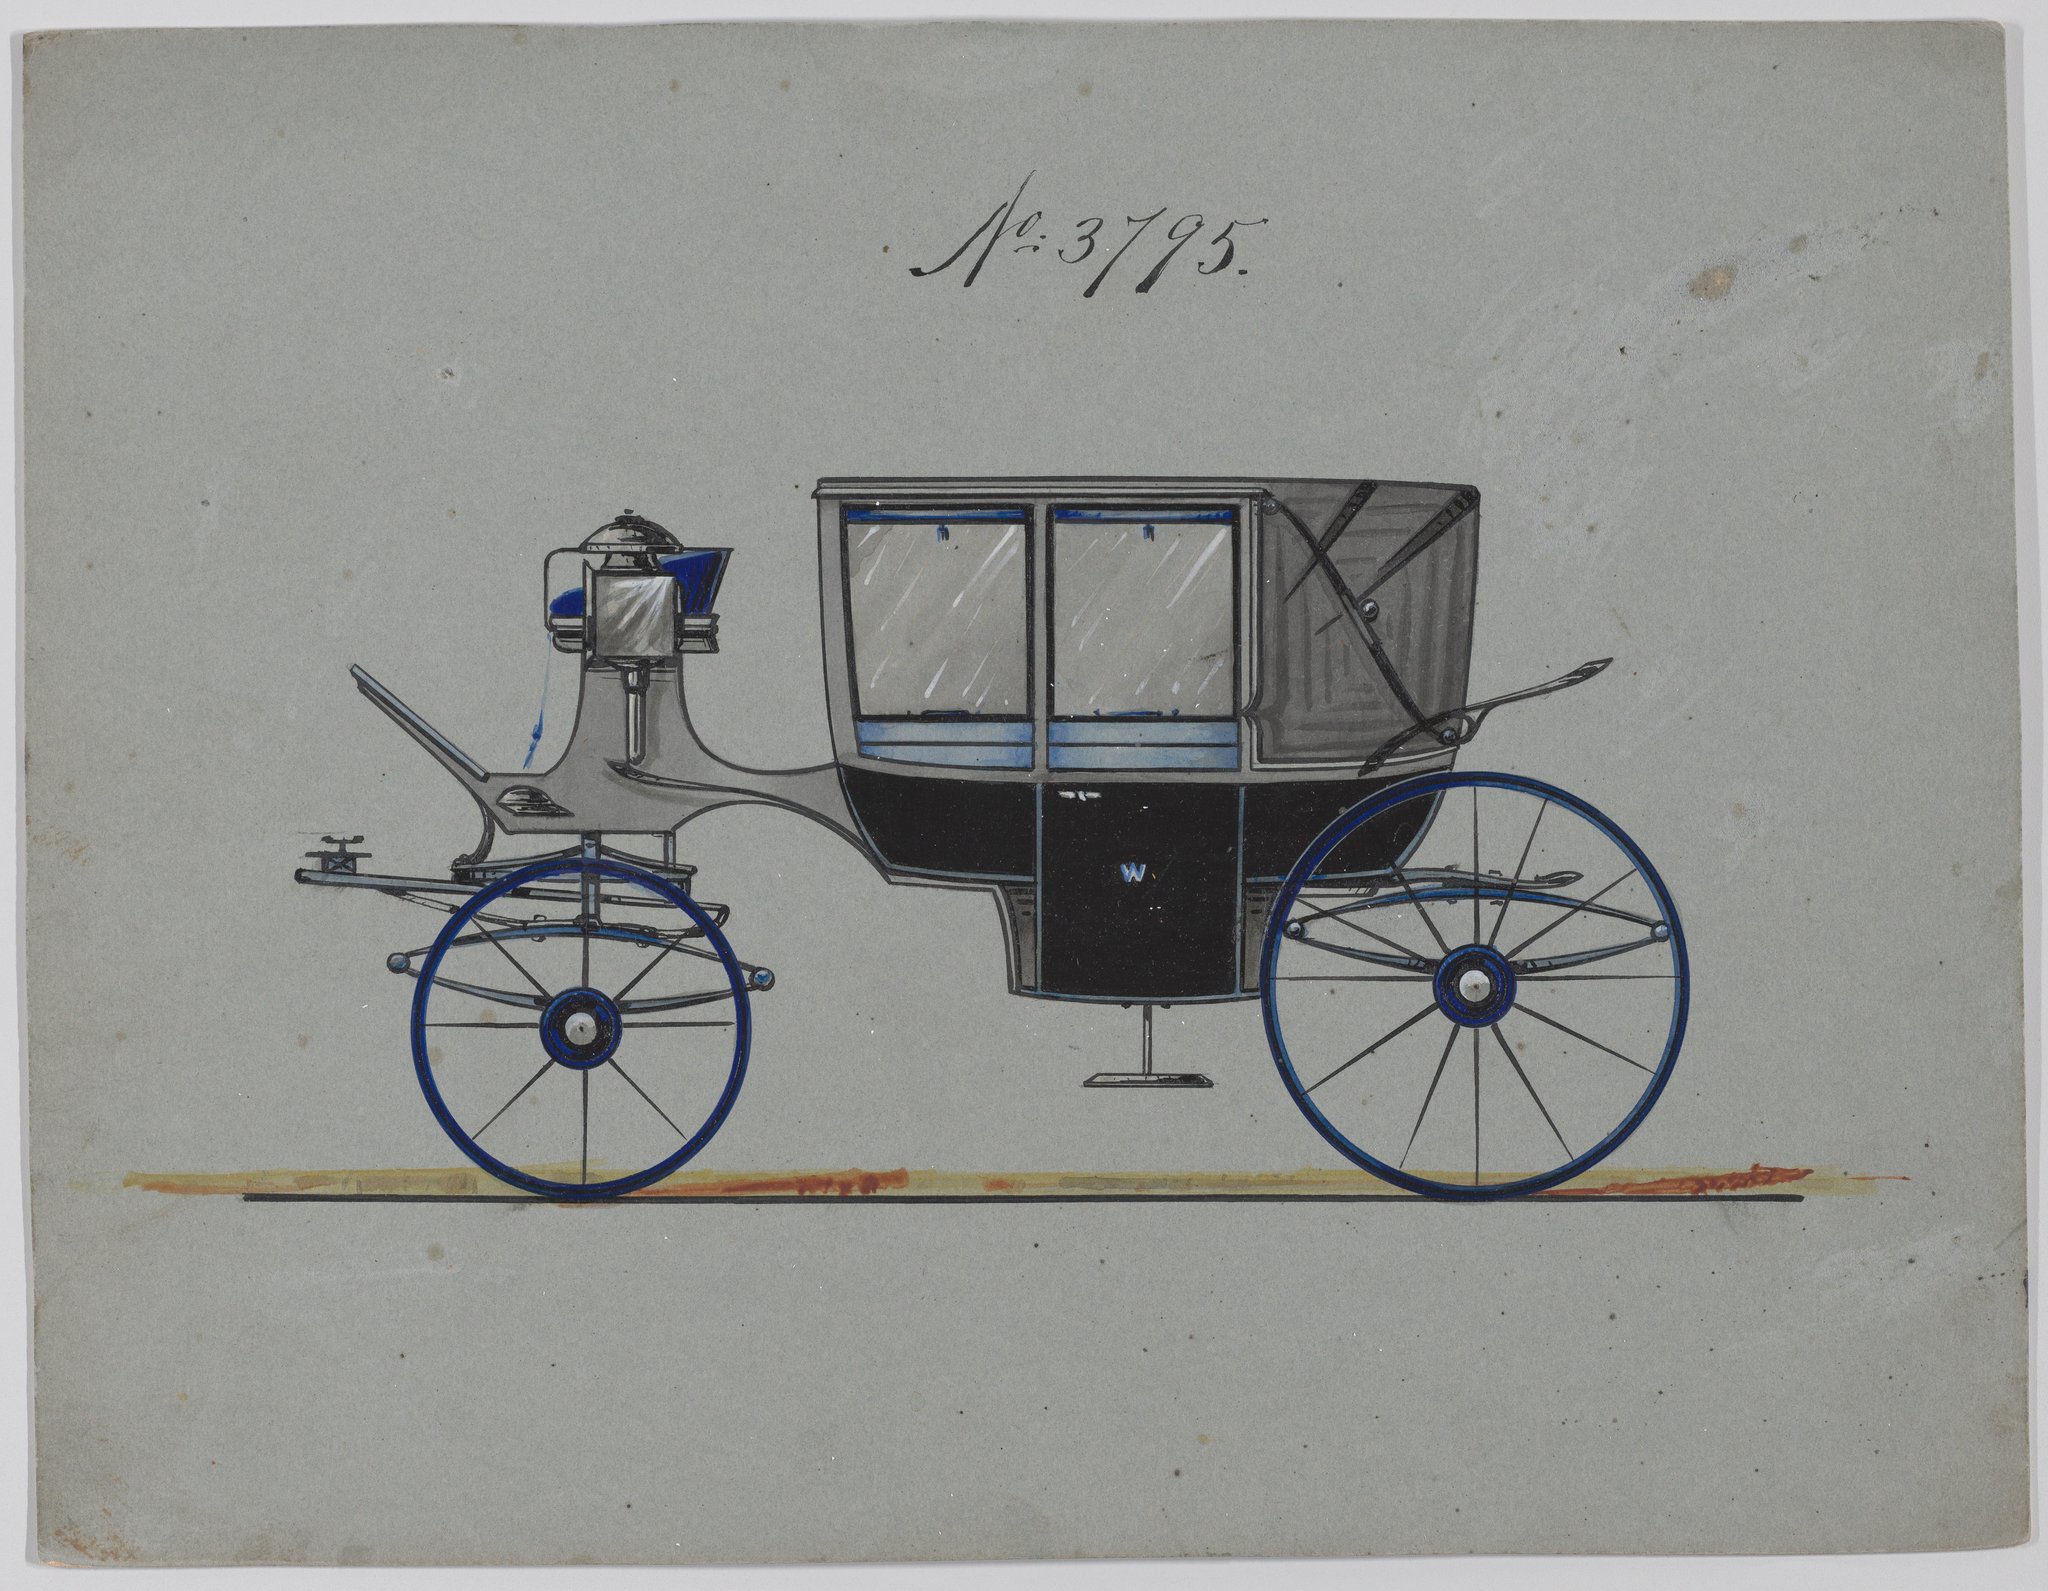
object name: drawing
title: Design for Landau, No. 3795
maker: brewster & co.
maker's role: manufacturer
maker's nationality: american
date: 1883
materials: gouache, gum arabic, ink, watercolor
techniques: pen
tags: carriages